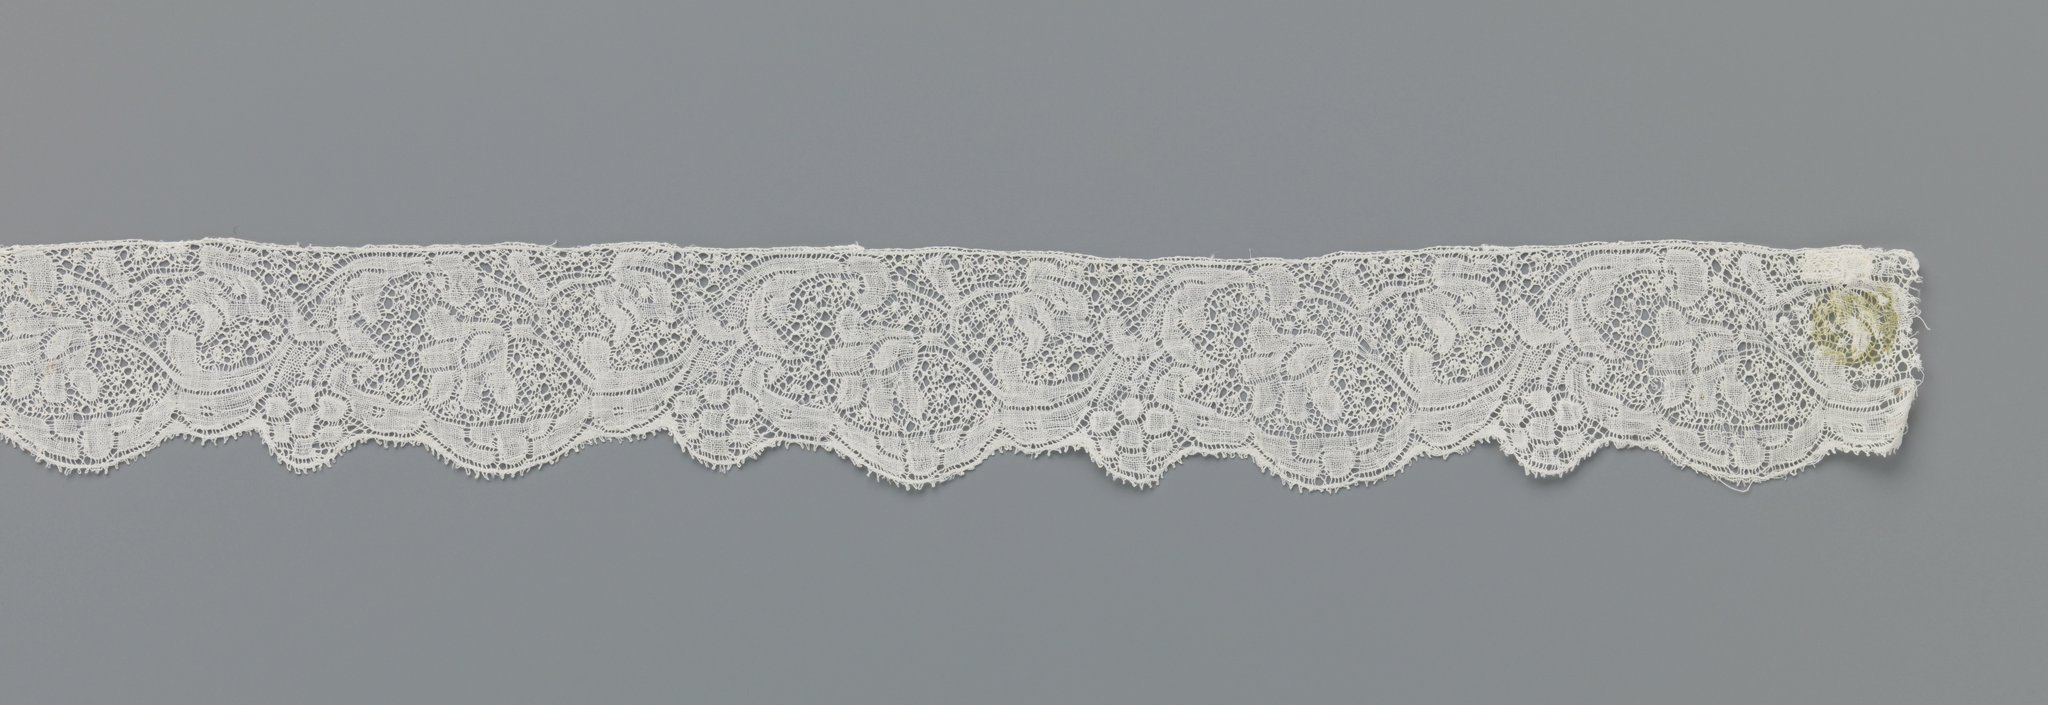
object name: strip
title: Strook kloskant met ranken en 'hoorn van overvloed'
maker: Anonymous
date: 1750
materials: linen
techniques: lace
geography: southern netherlands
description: Strook naturelkleurige kloskant, Binche-kant. Op een geringde sneeuwvlokkengrond staat een lopend patroon. Aan een golvend rankje groeien twee kelkbloempjes en een bij een bladknop beginnende 'hoorn van overvloed' met een trosbloem, die in voluutbladeren gevat, met deze de schulpjes vormt. De bovenzijde van de strook is recht afgewerkt. De schulpenrand langs de onderzijde is afgewerkt met picots.